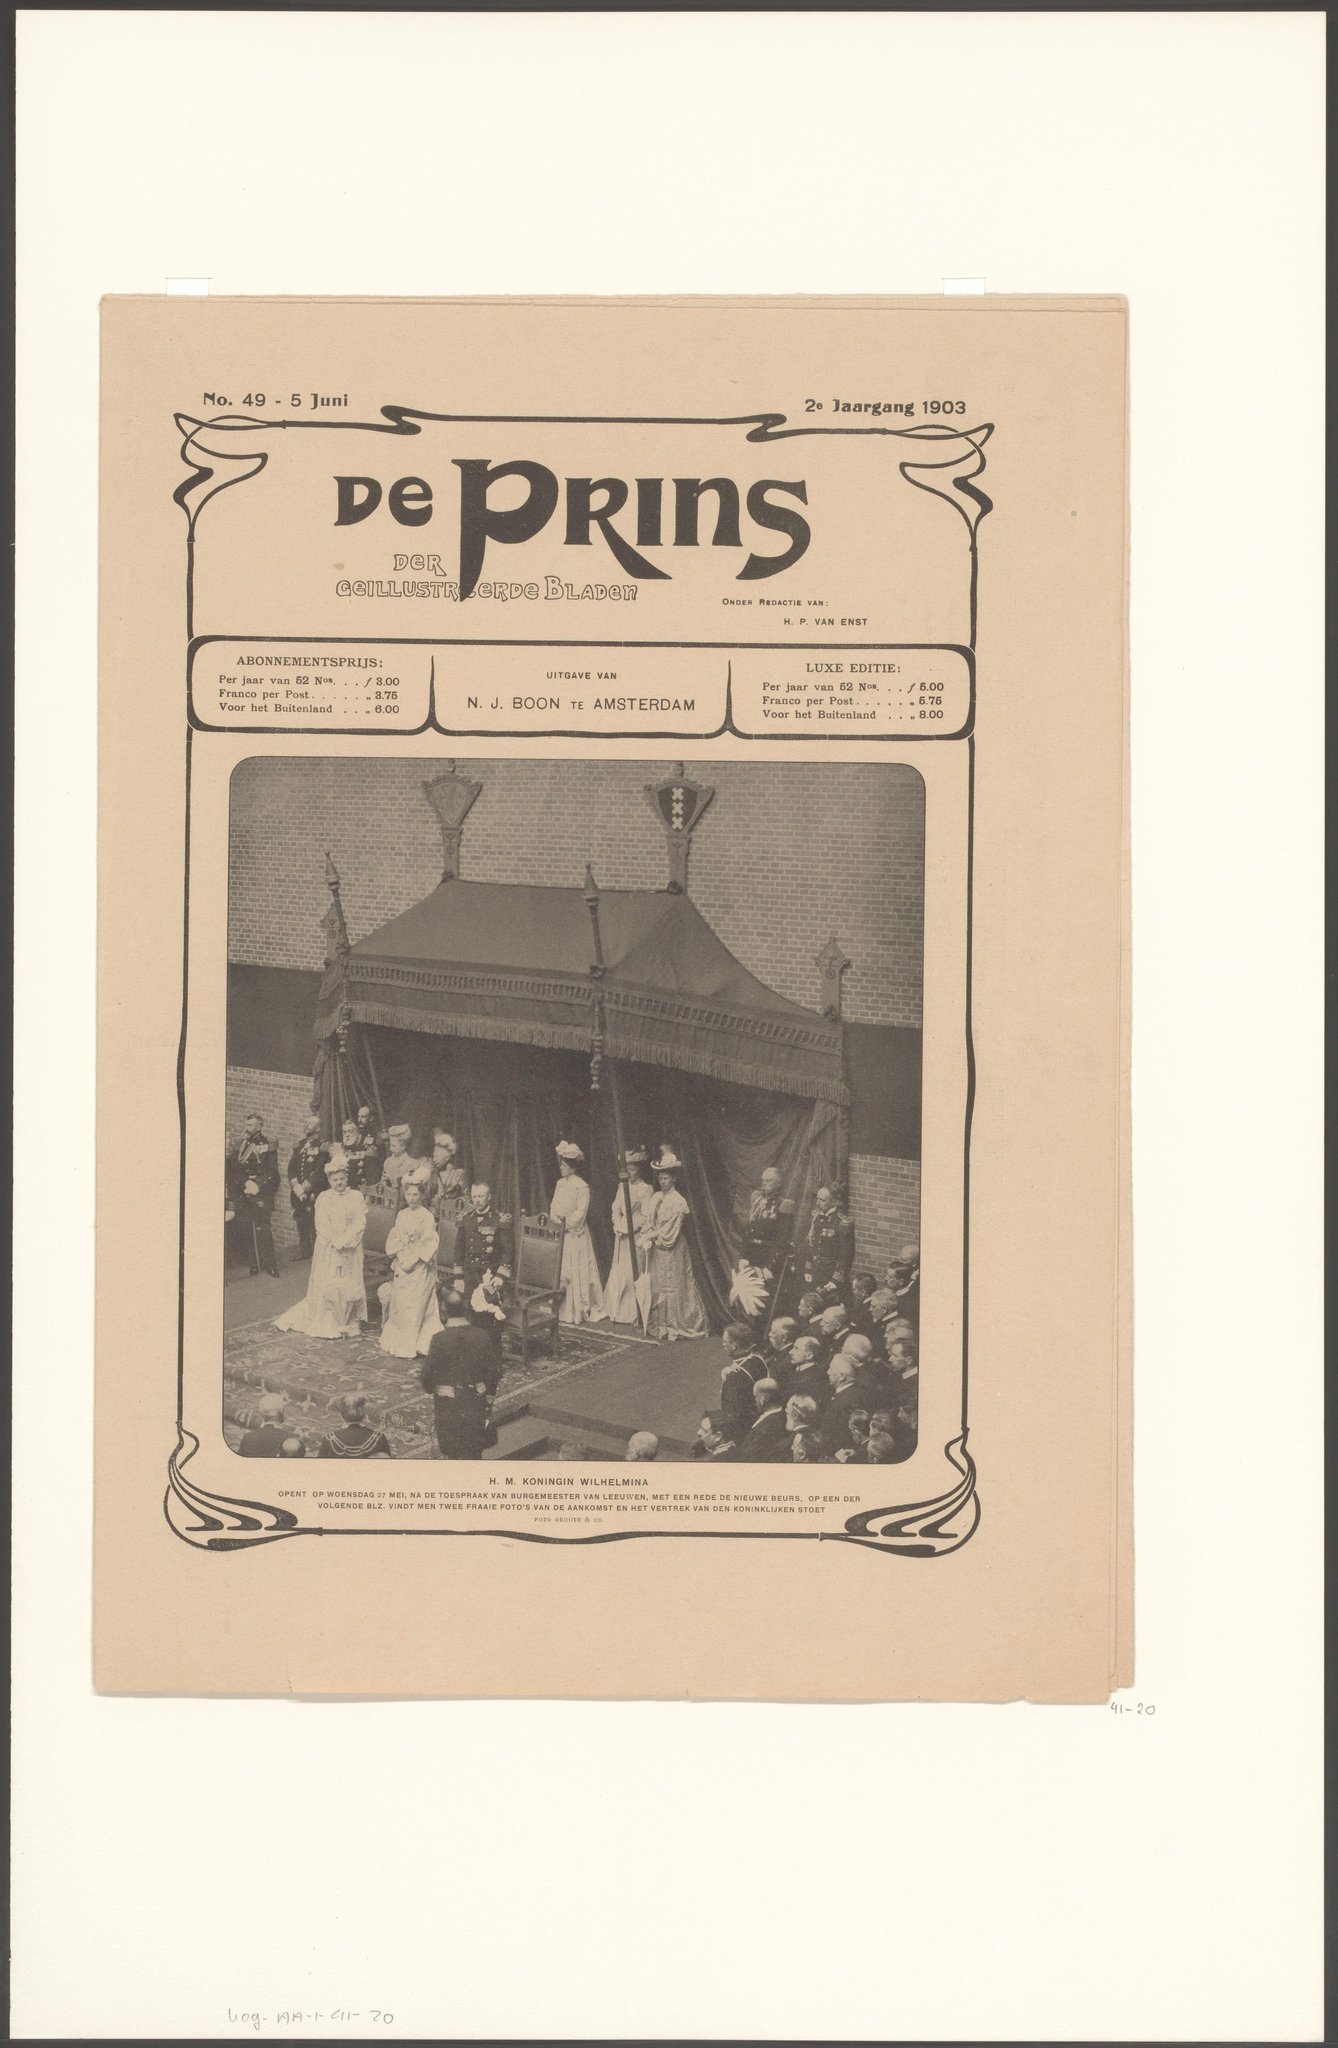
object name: magazine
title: Wilhelmina, koningin der Nederlanden opent de Beurs van Berlage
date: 1903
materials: paper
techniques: letterpress printing, line block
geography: amsterdam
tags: wilhelmina of the netherlands, stock exchange, stock-market, amsterdam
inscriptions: collector's mark: Lugt 1461b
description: Het tijdschrift De Prins van 5 juni 1903, met een reportage over de opening van de Beurs van Berlage door Wilhelmina, koningin der Nederlanden. Het tijdschrift bestaat uit twaalf pagina's. Onderwerpsrubriek binnen de Atlas Amsterdam: B. Beurs op het Damrak.